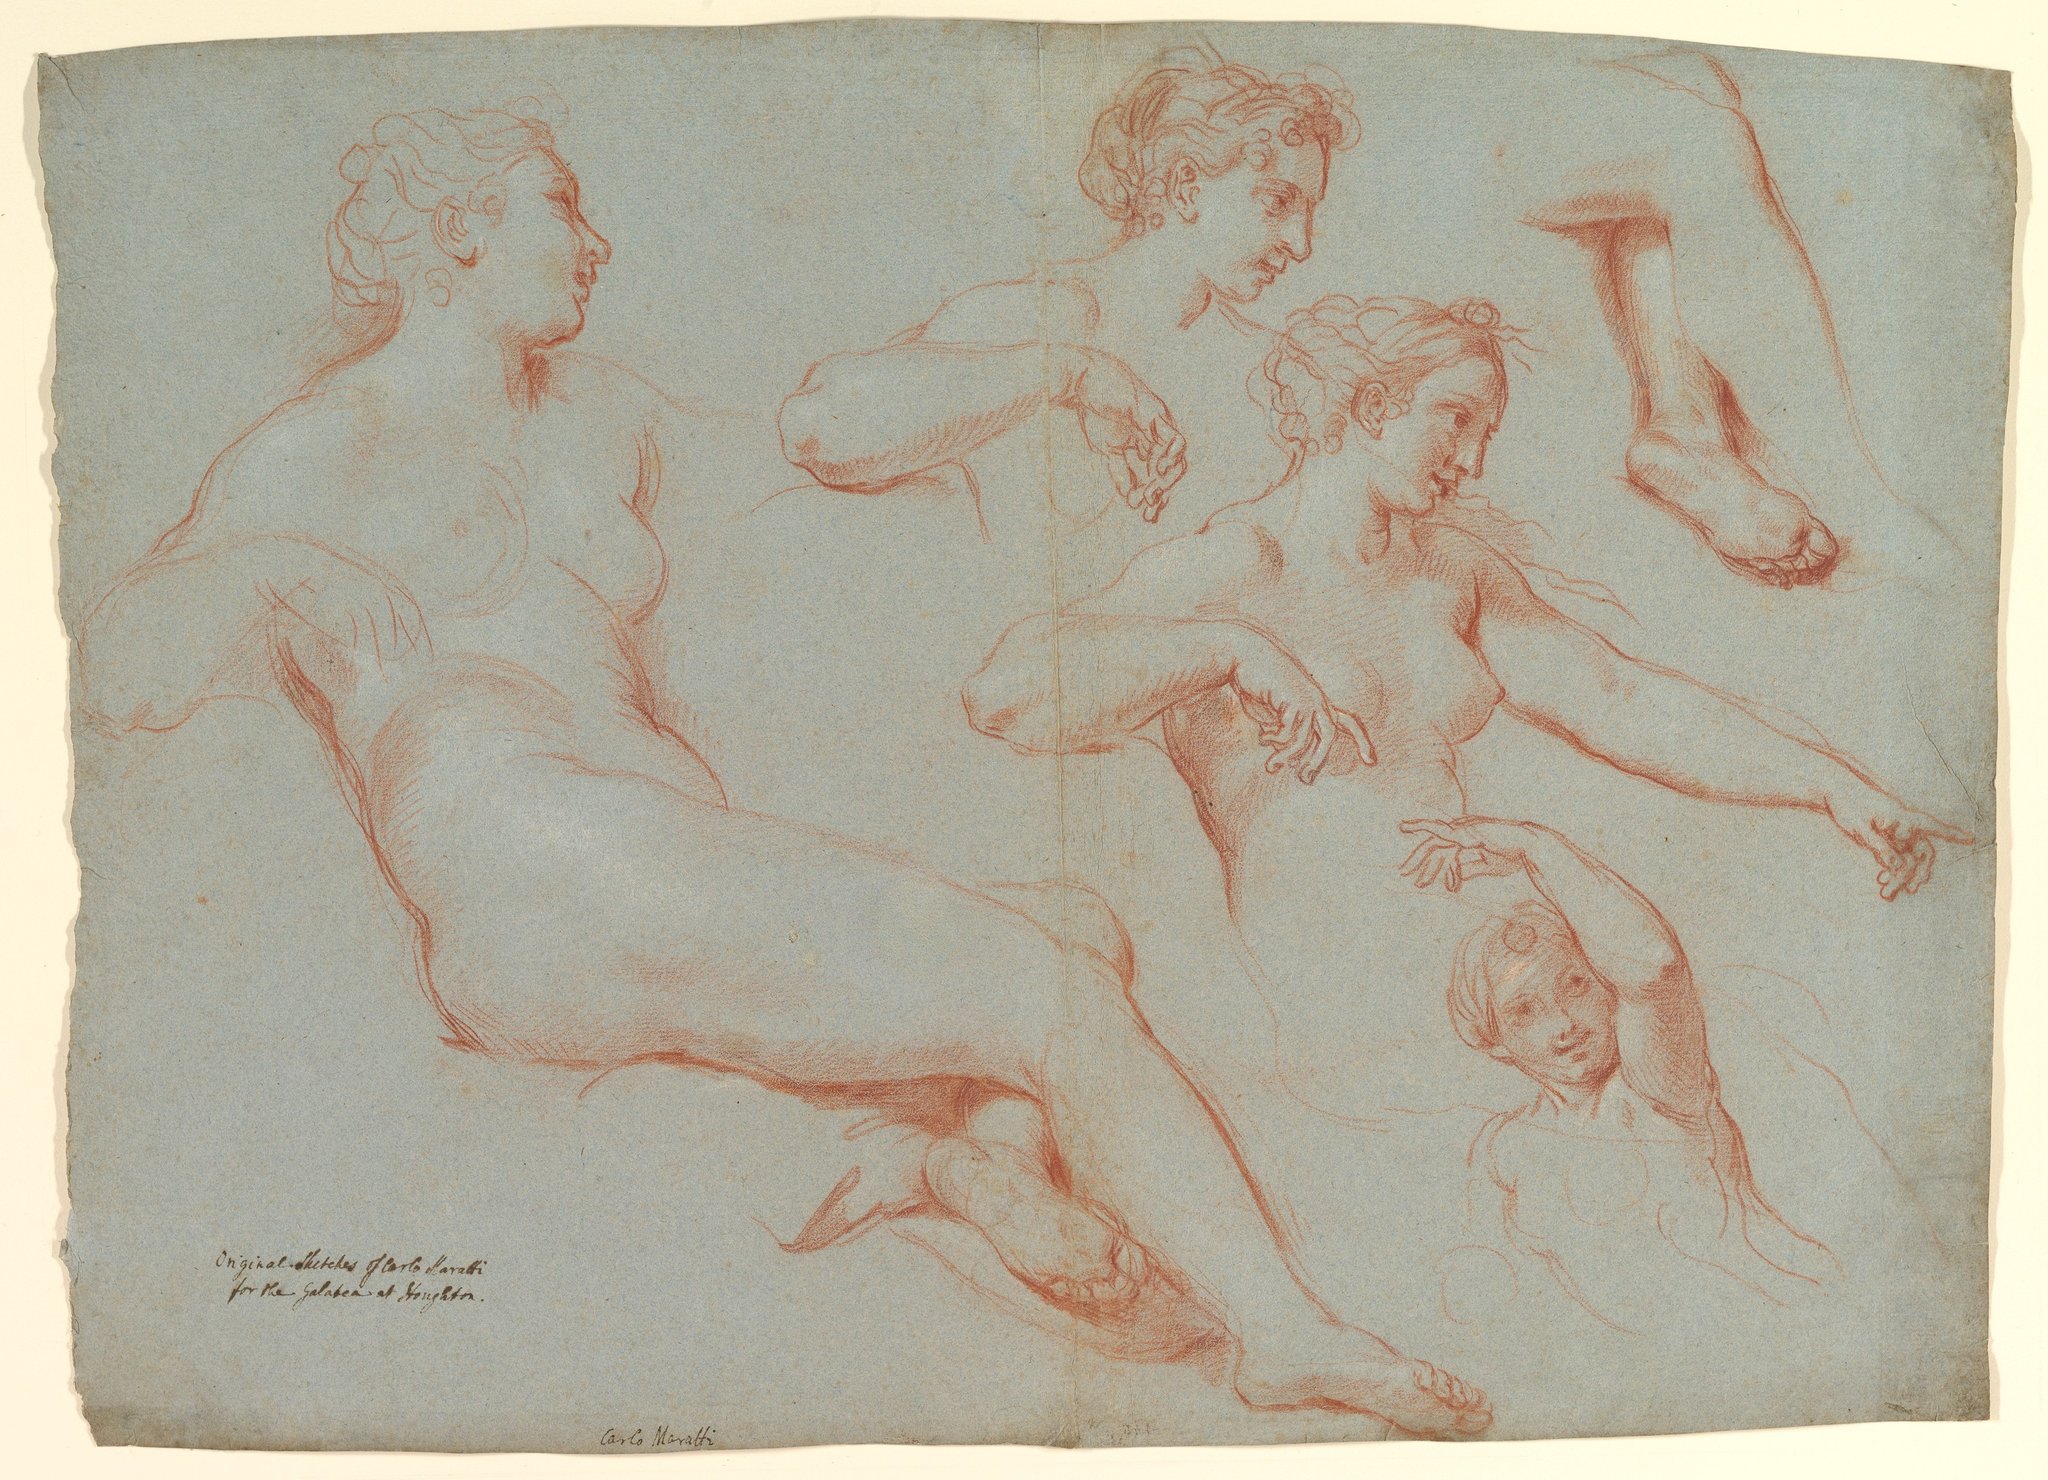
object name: drawing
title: Four Studies of Recumbent Female Nudes (Galatea)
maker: carlo maratti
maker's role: artist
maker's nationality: italian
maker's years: 1625-1713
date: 1713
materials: chalk, paper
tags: female nudes